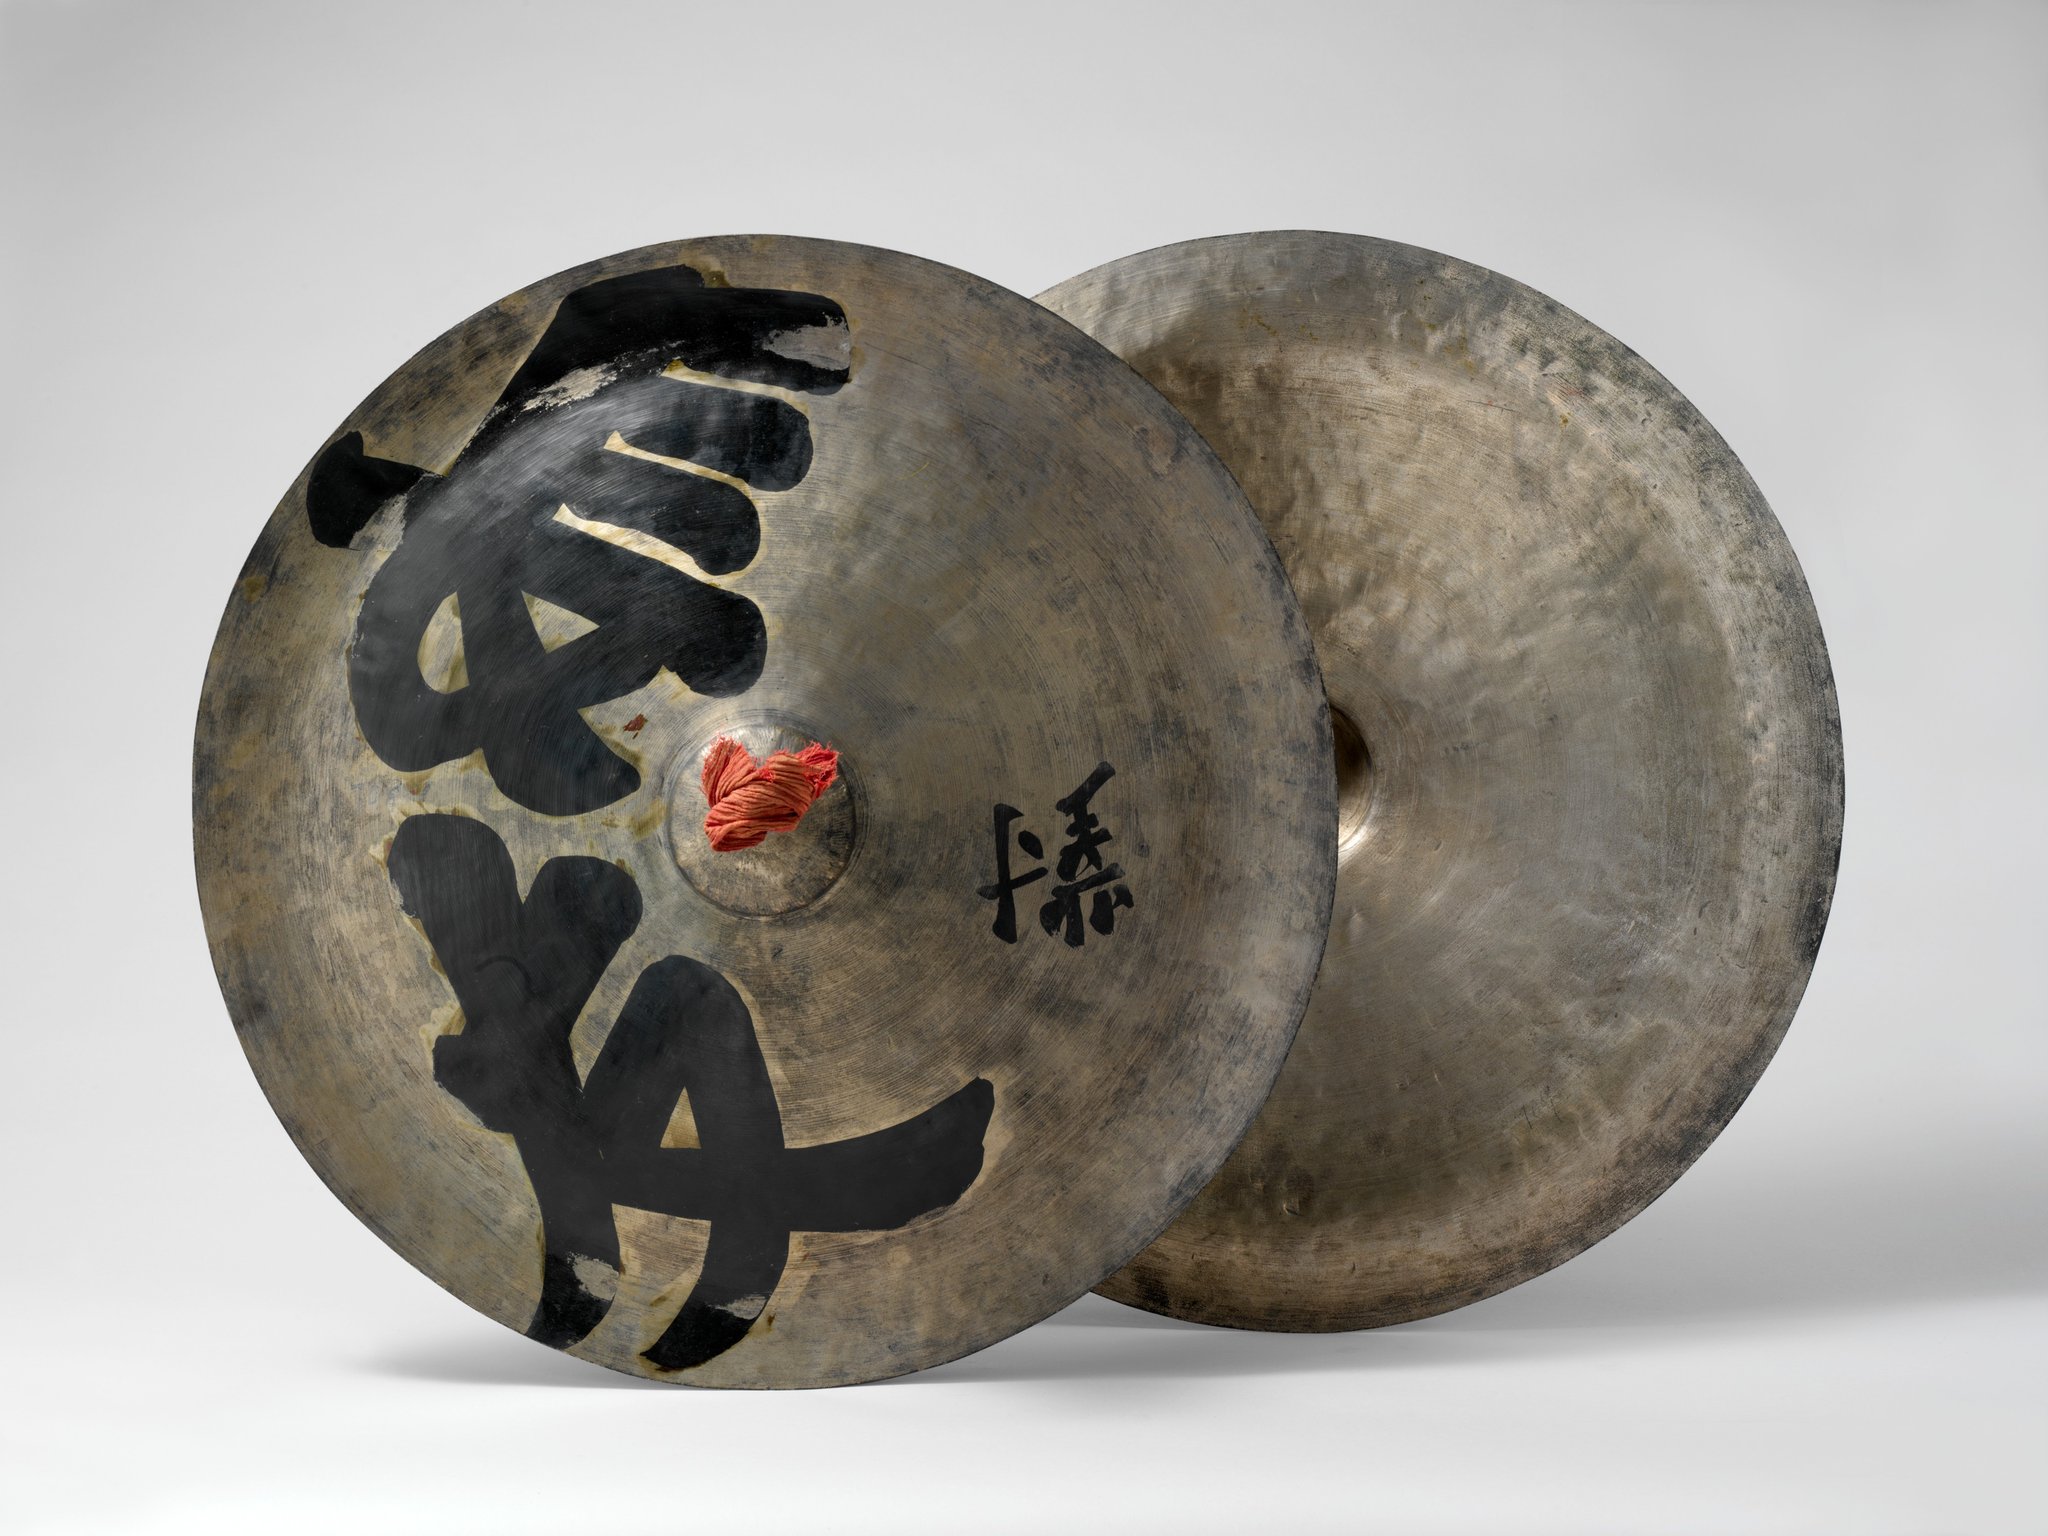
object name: po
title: Po (鈸 )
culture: chinese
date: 1801-1900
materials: metal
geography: china